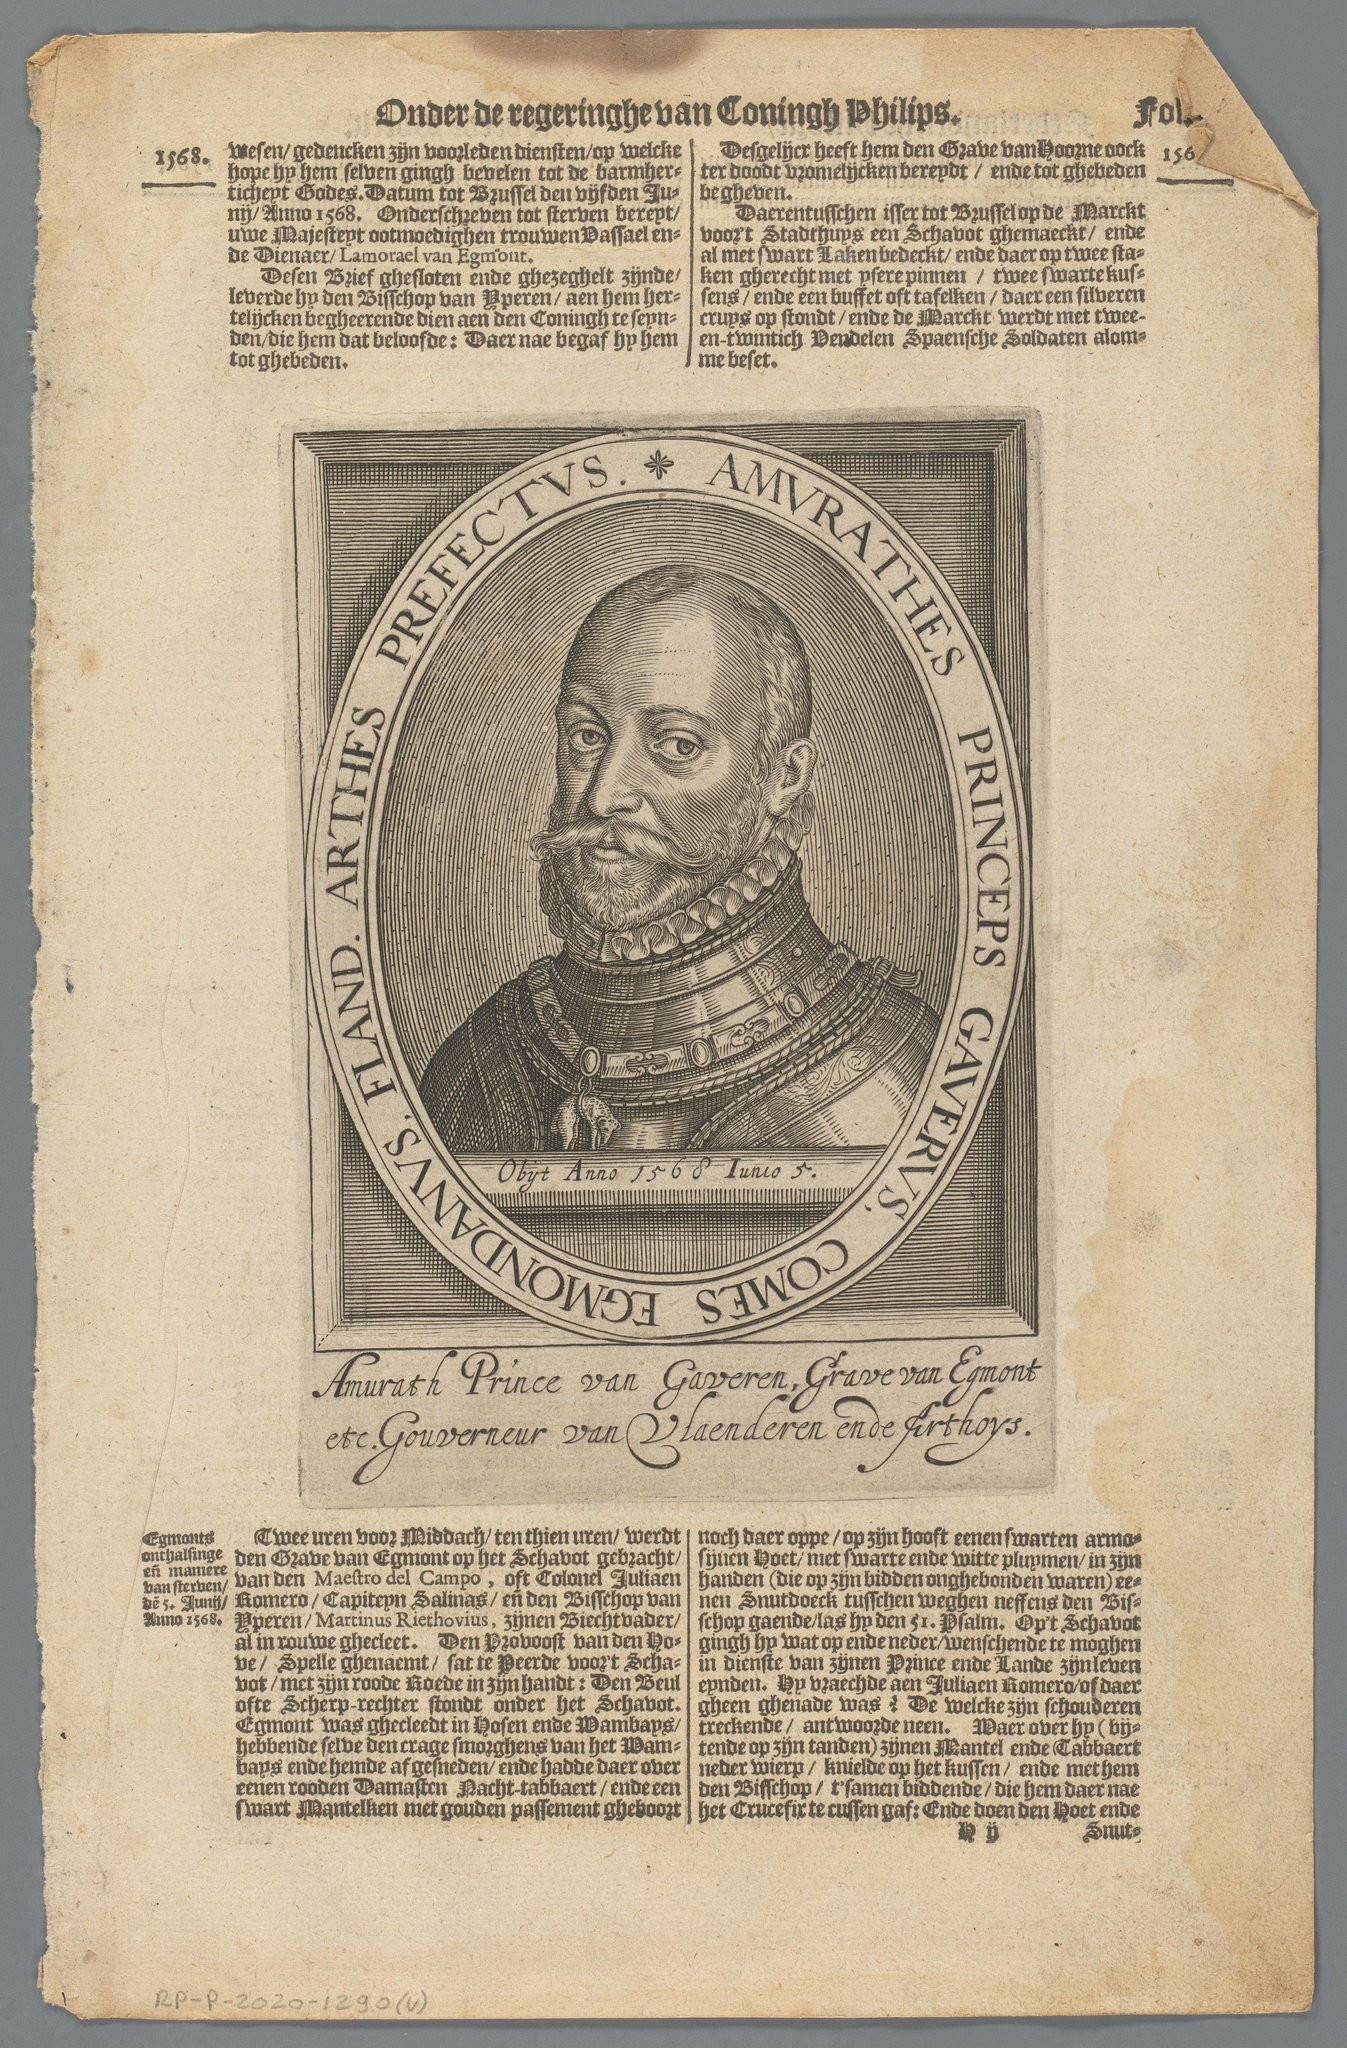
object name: book illustration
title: Amurathes princeps Gaverus, comes Egmondanus. Fland. arthes prefectus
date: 1614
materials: paper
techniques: engraving, letterpress printing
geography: the hague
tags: brussels, historical persons, nobility and patriciate; chivalry, knighthood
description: Prent uit: Meteren, Emanuel van. Historie der Nederlandscher ende haerder na-buren oorlogen ende geschiedenissen (...). Den Haag: Hillebrant Iacobsz. van Wouw, 1614.